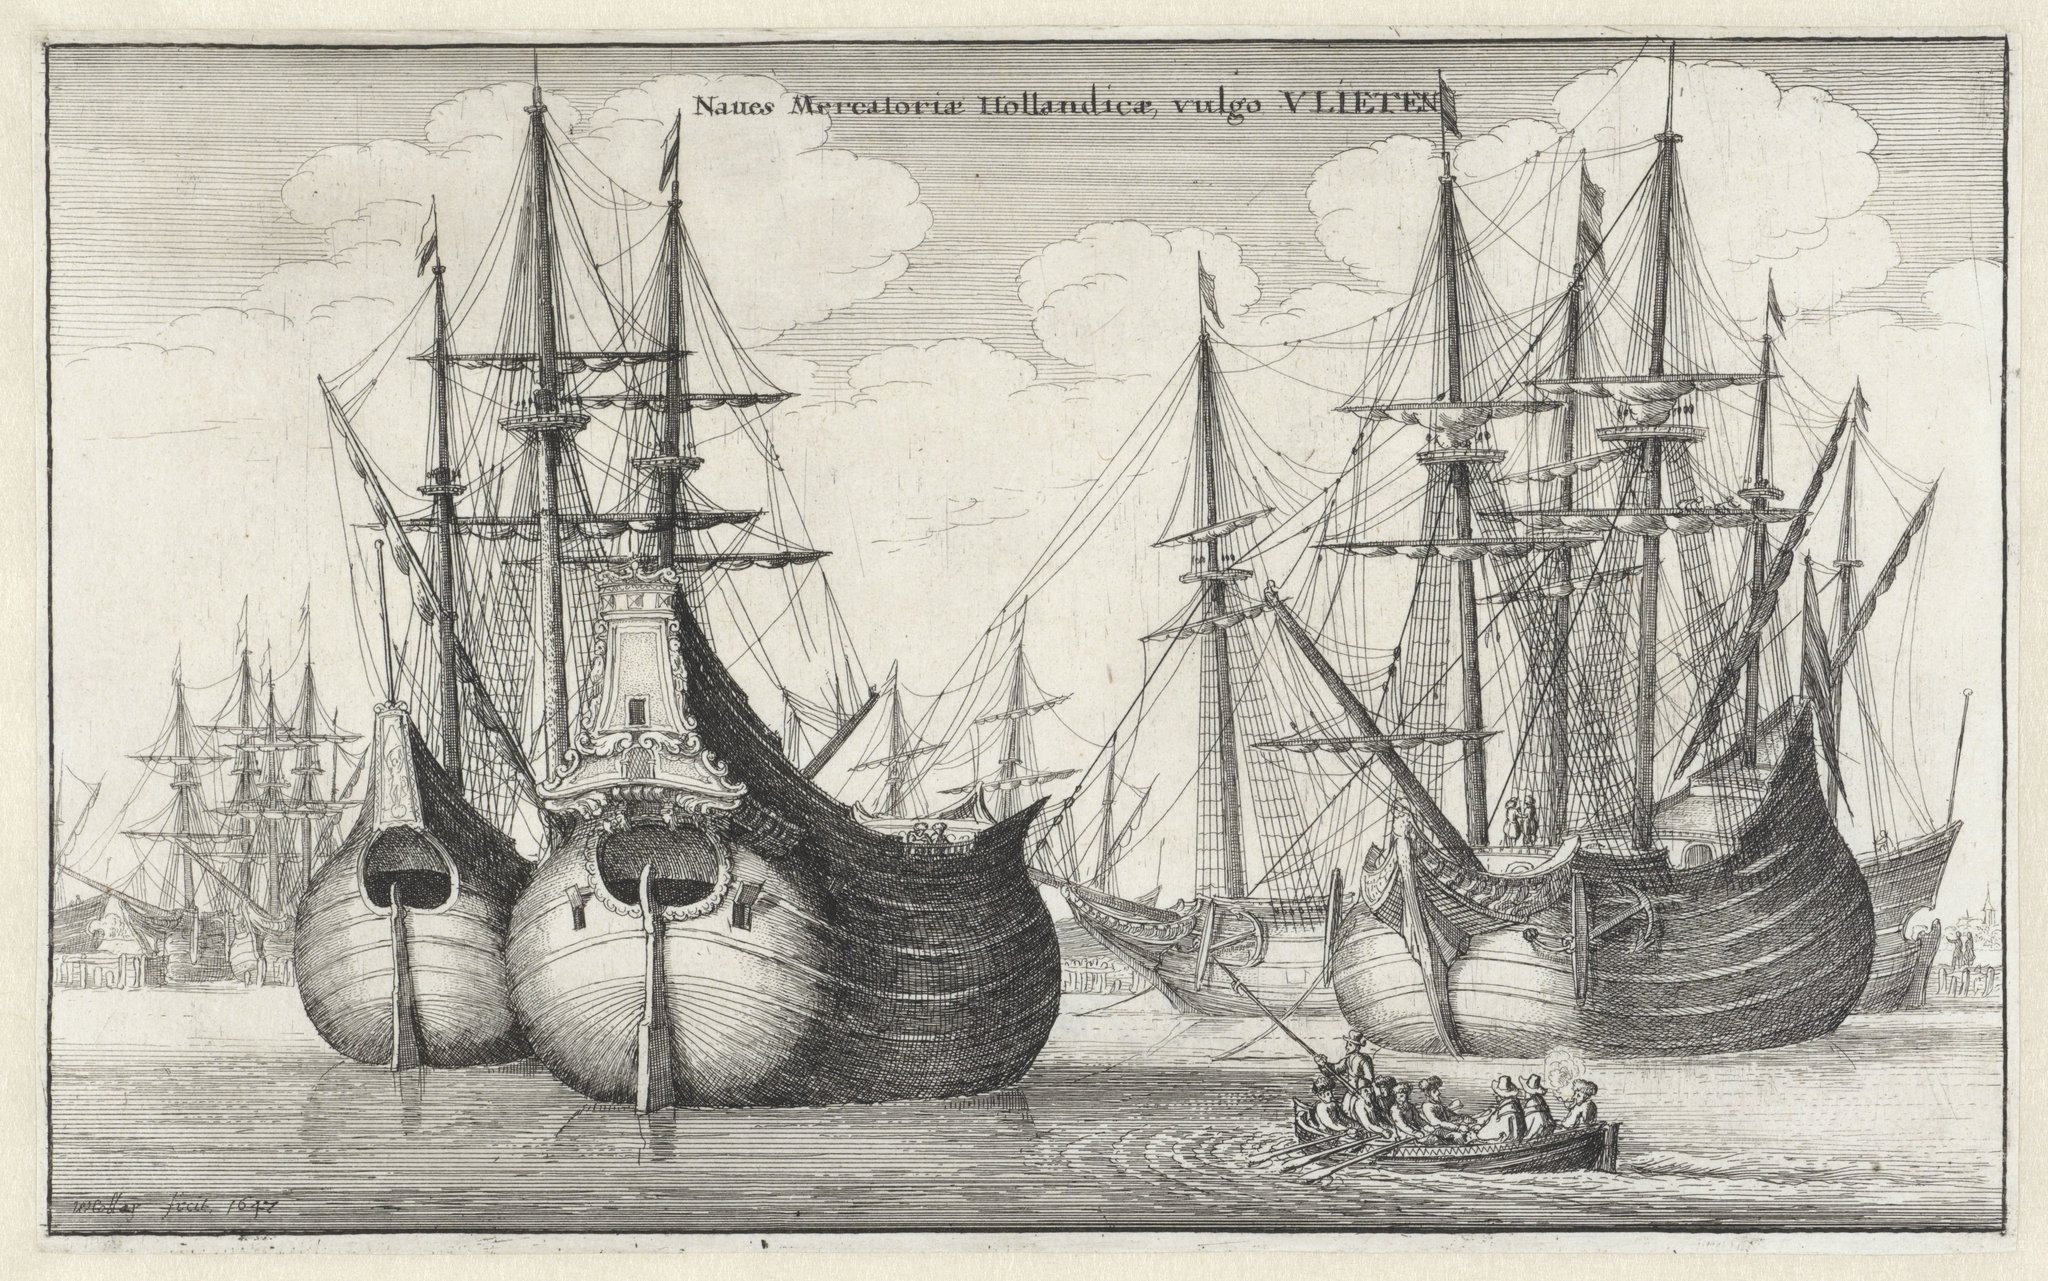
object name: print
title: Navium Variae Figurae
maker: wenceslaus hollar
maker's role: draughtsman, print maker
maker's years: 1607-1677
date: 1647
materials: paper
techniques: etching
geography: antwerp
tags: sailing-ship, sailing-boat (with name)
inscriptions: collector's mark: Lugt 240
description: De prent maakt deel uit van de twaalfdelige serie "Navium Variae Figurae".